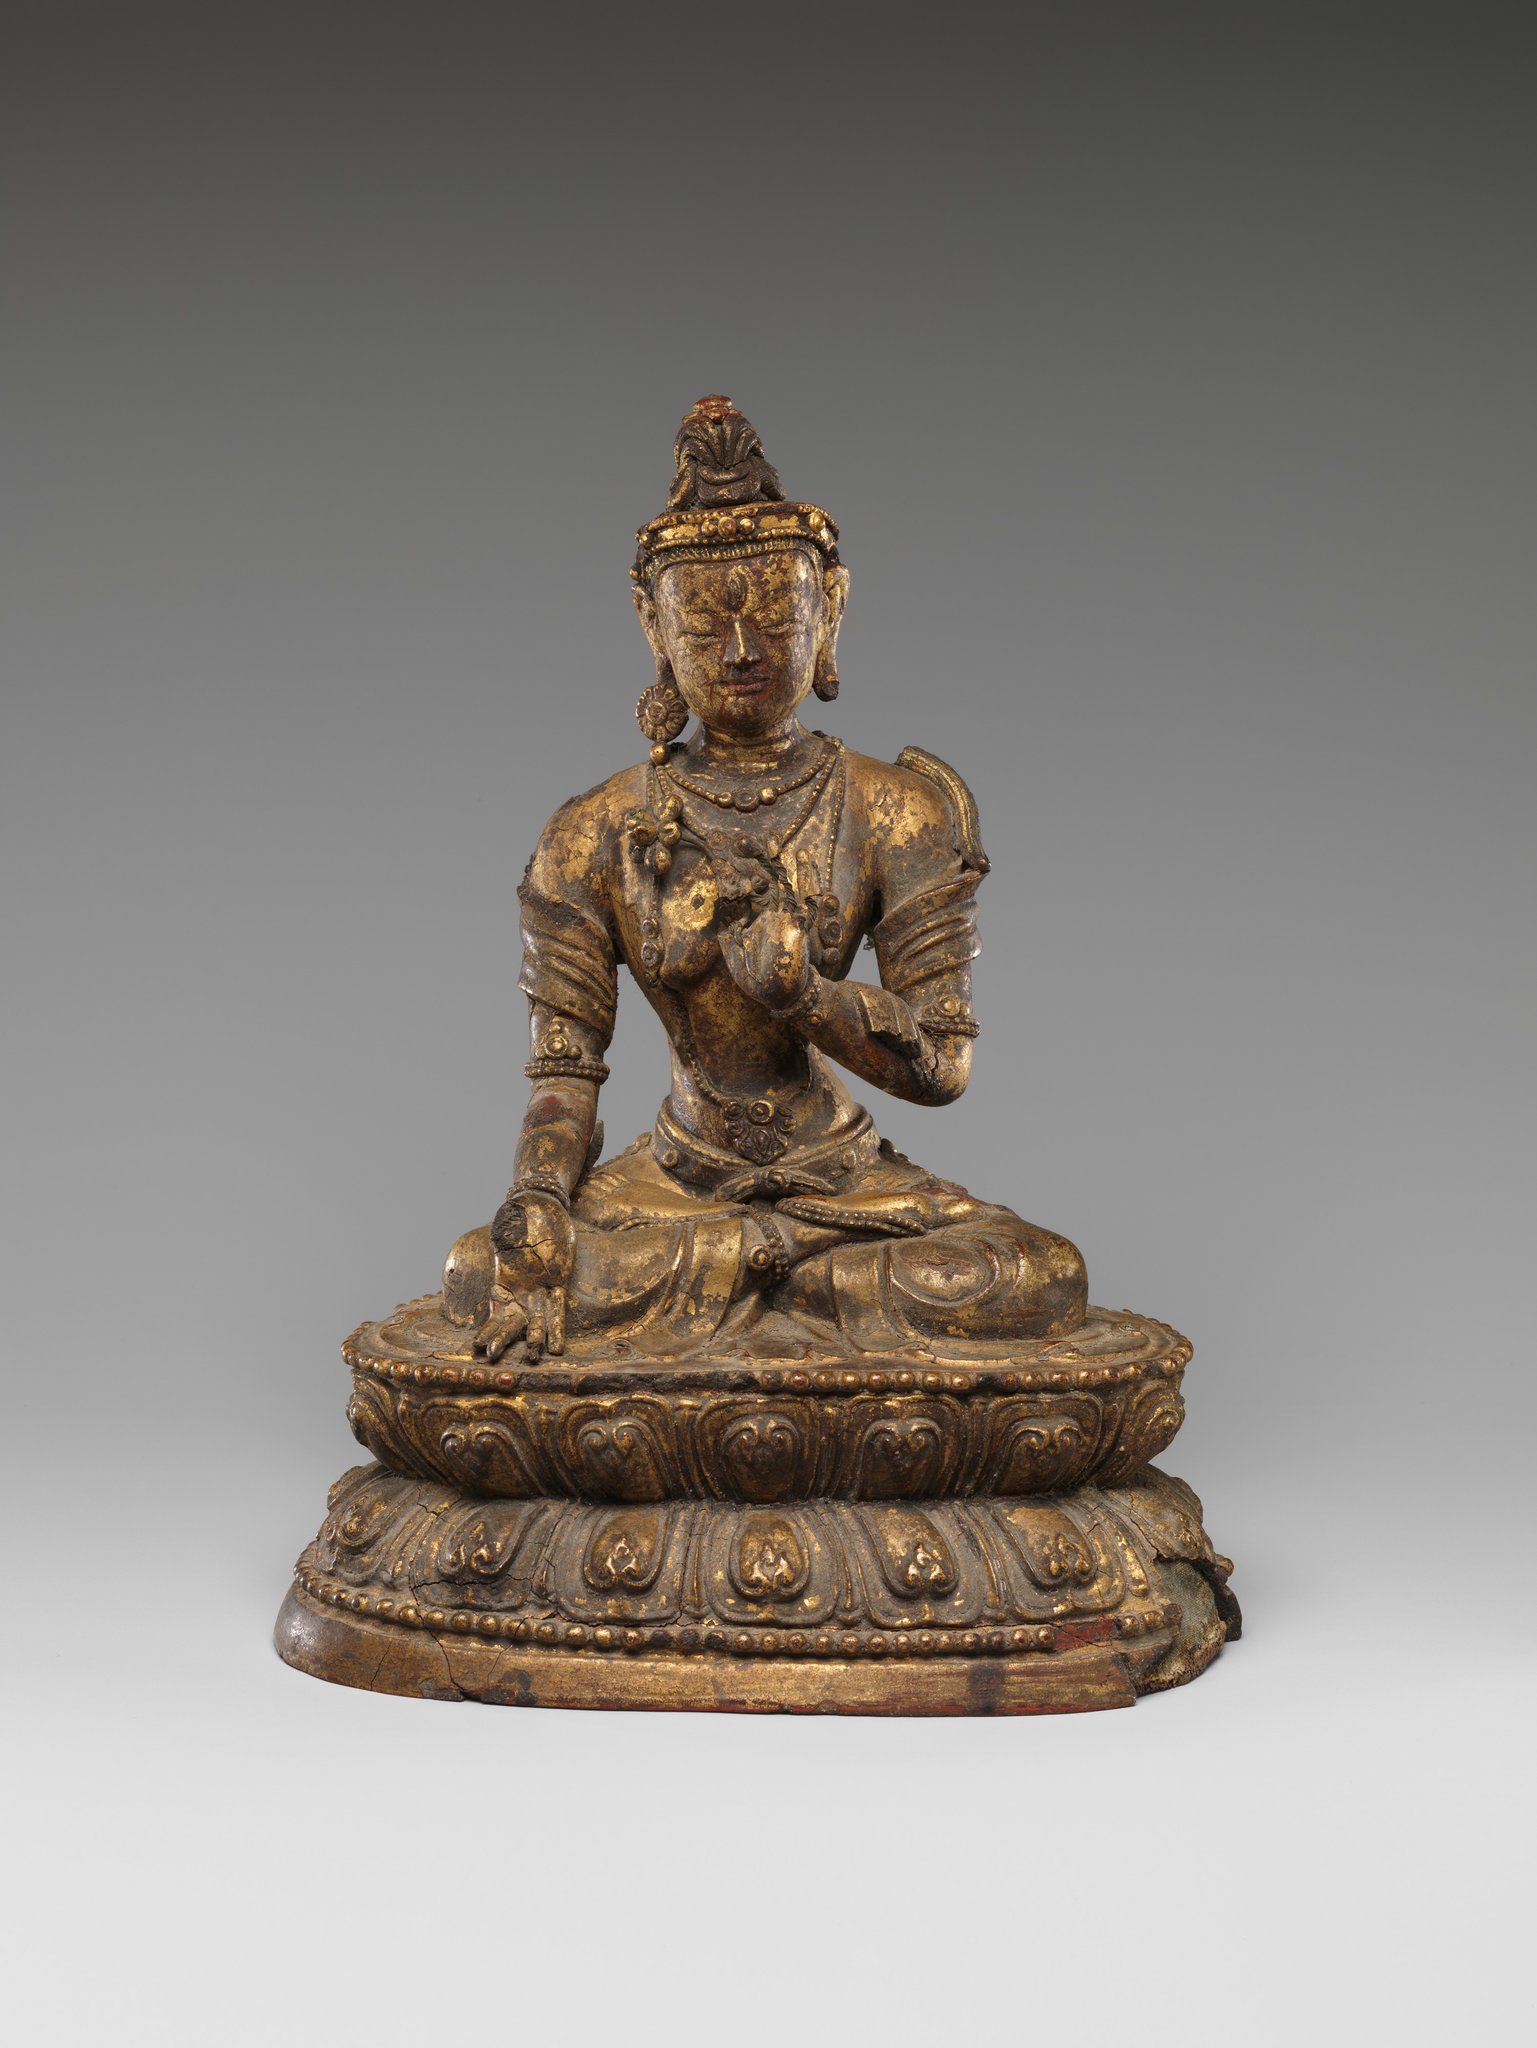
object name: statuette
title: Seated Tara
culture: tibetan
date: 1401-1600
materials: lacquer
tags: buddhism